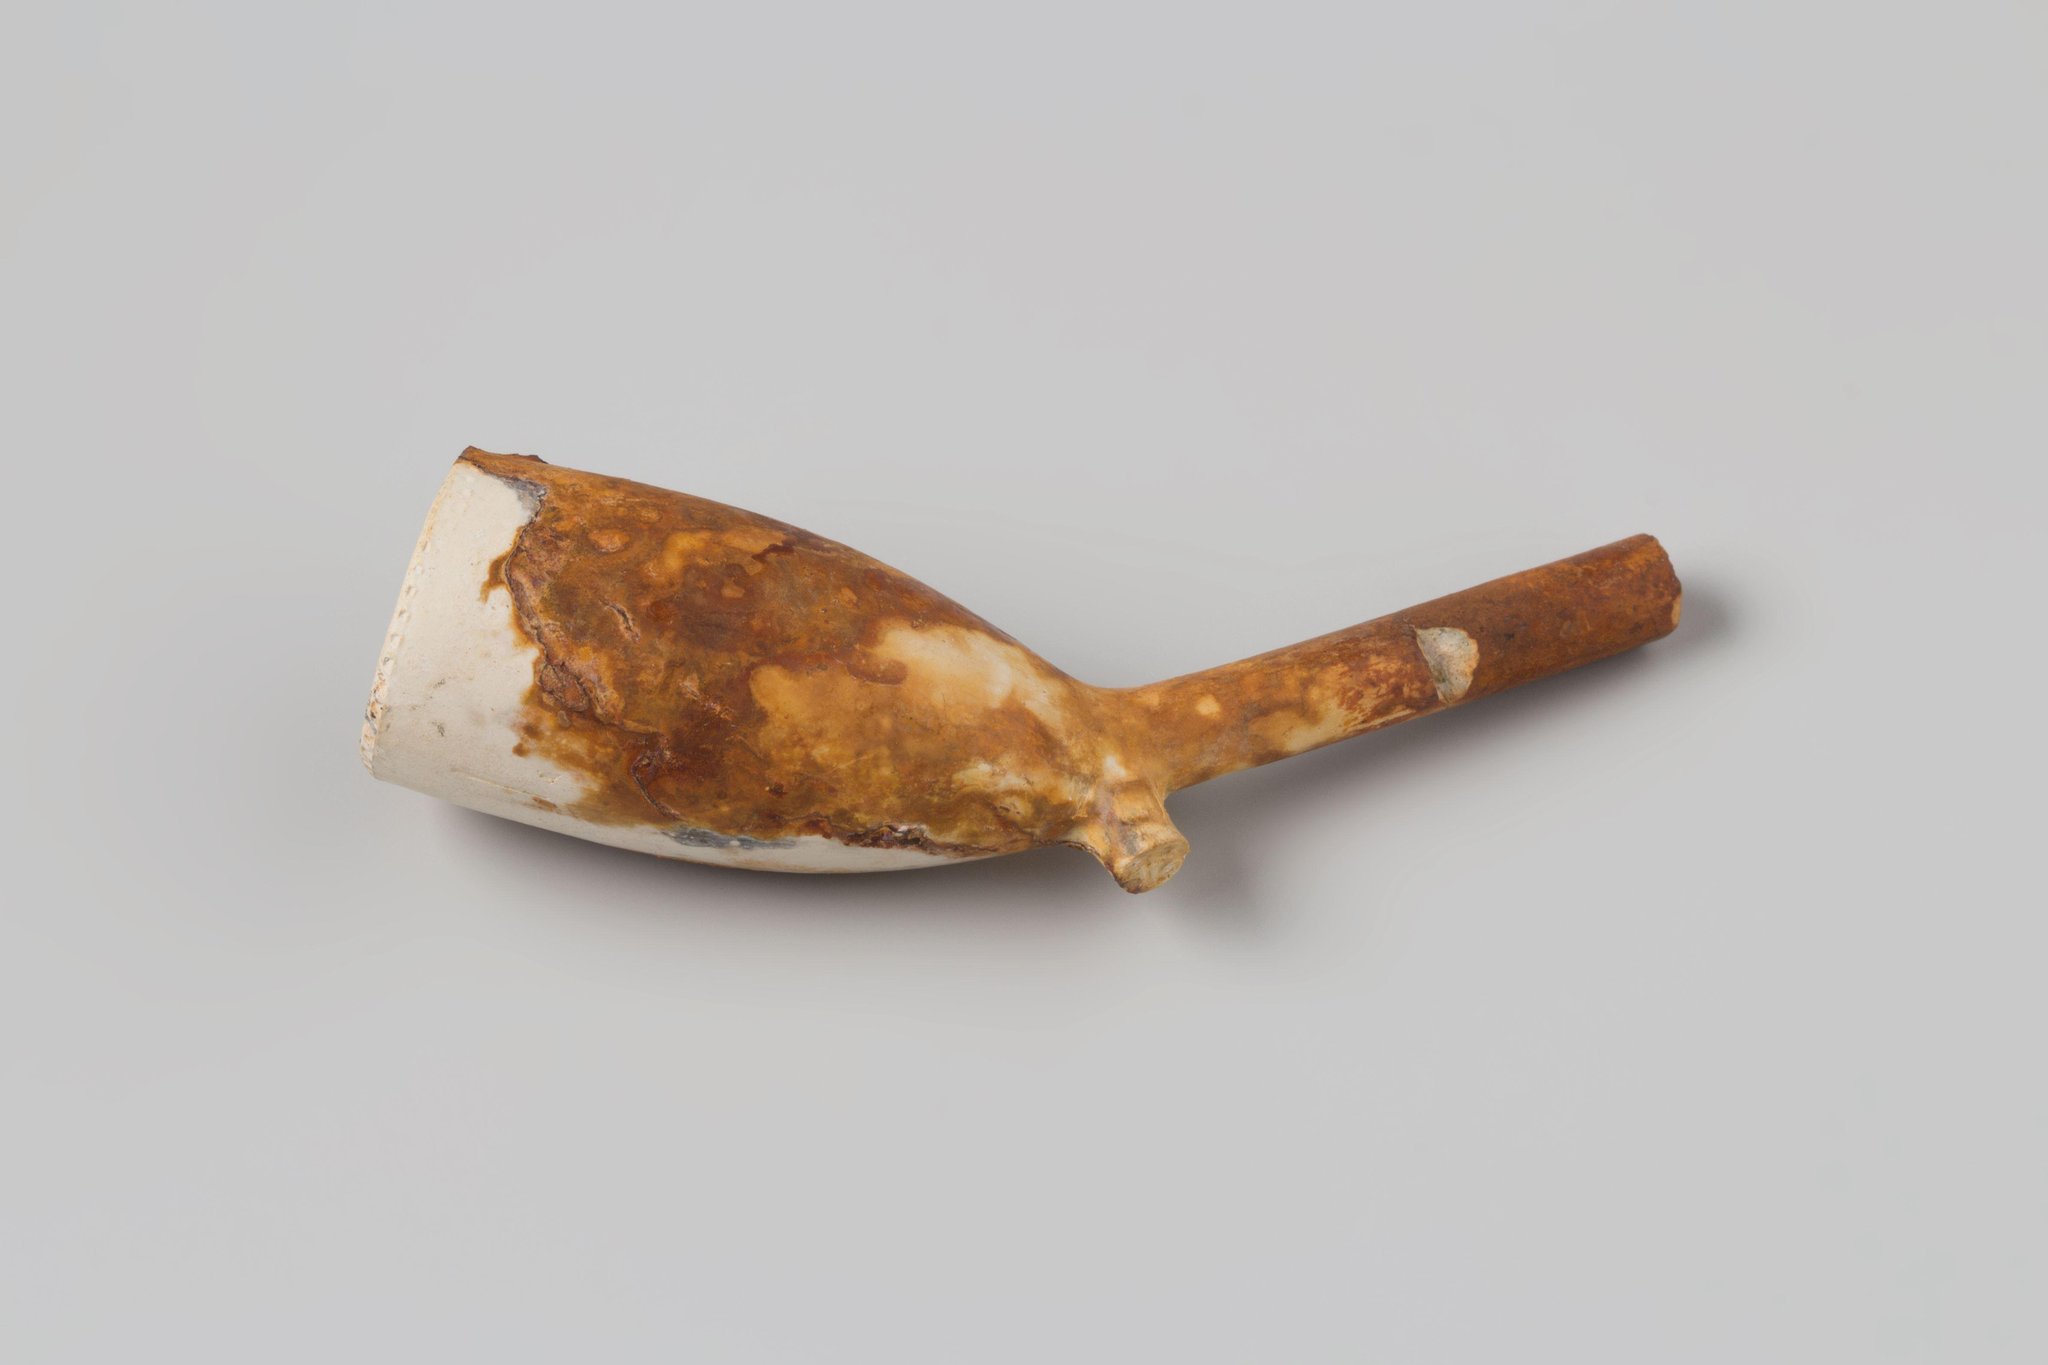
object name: pipe bowl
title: Pijpenkop met stuk steel uit het wrak van de Oost-Indiëvaarder Hollandia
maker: Anonymous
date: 1700-1743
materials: clay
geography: netherlands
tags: verenigde oostindische compagnie, hollandia (schip), annet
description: Pipe, bowl, heelmark: crowned 57; 2hsm1.